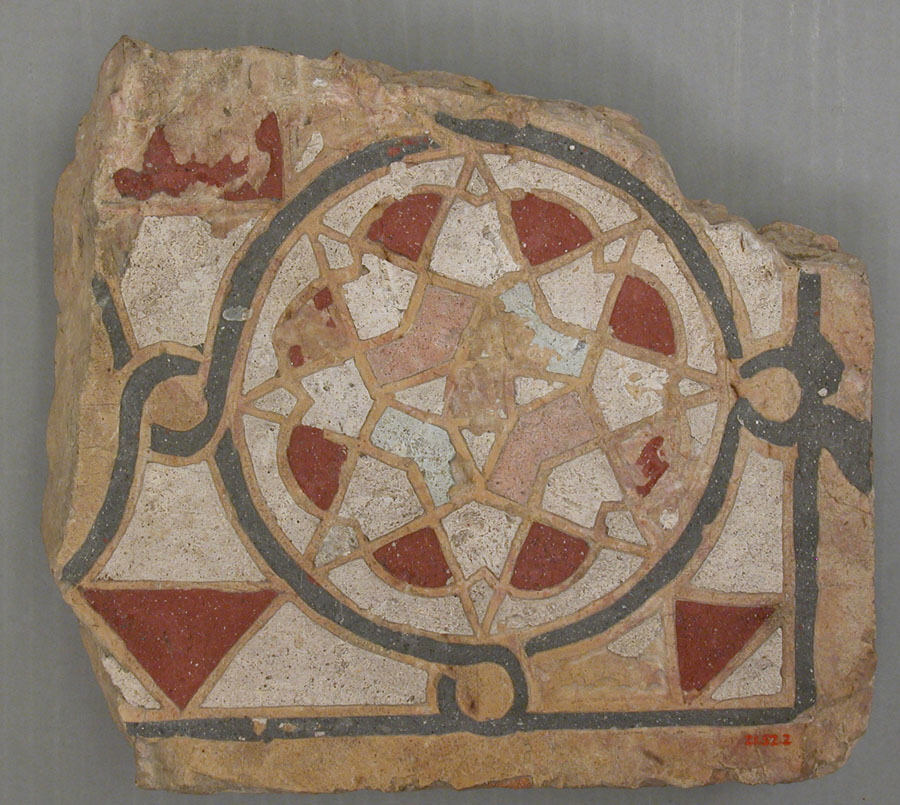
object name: tile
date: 1101-1400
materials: earthenware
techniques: glazing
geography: egypt